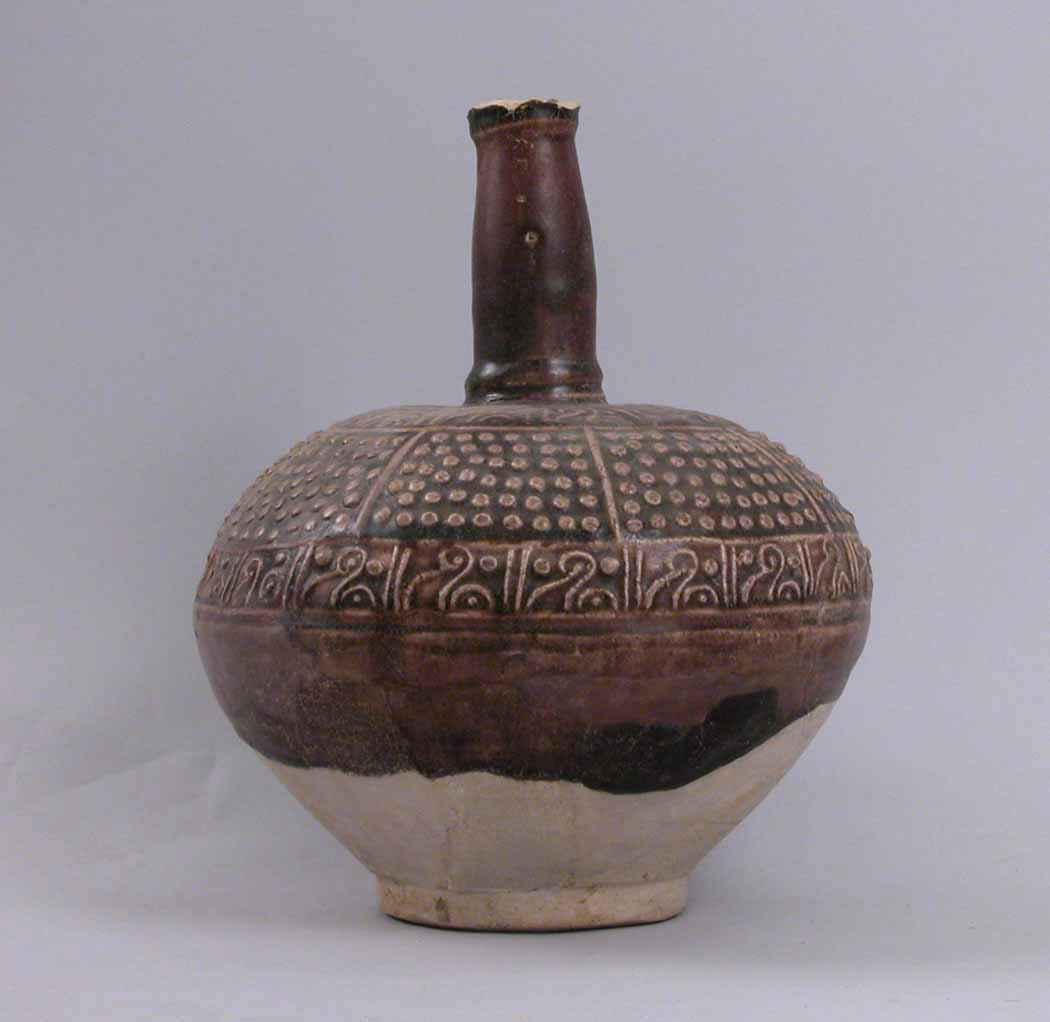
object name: bottle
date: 1101-1300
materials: earthenware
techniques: glazing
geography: iran